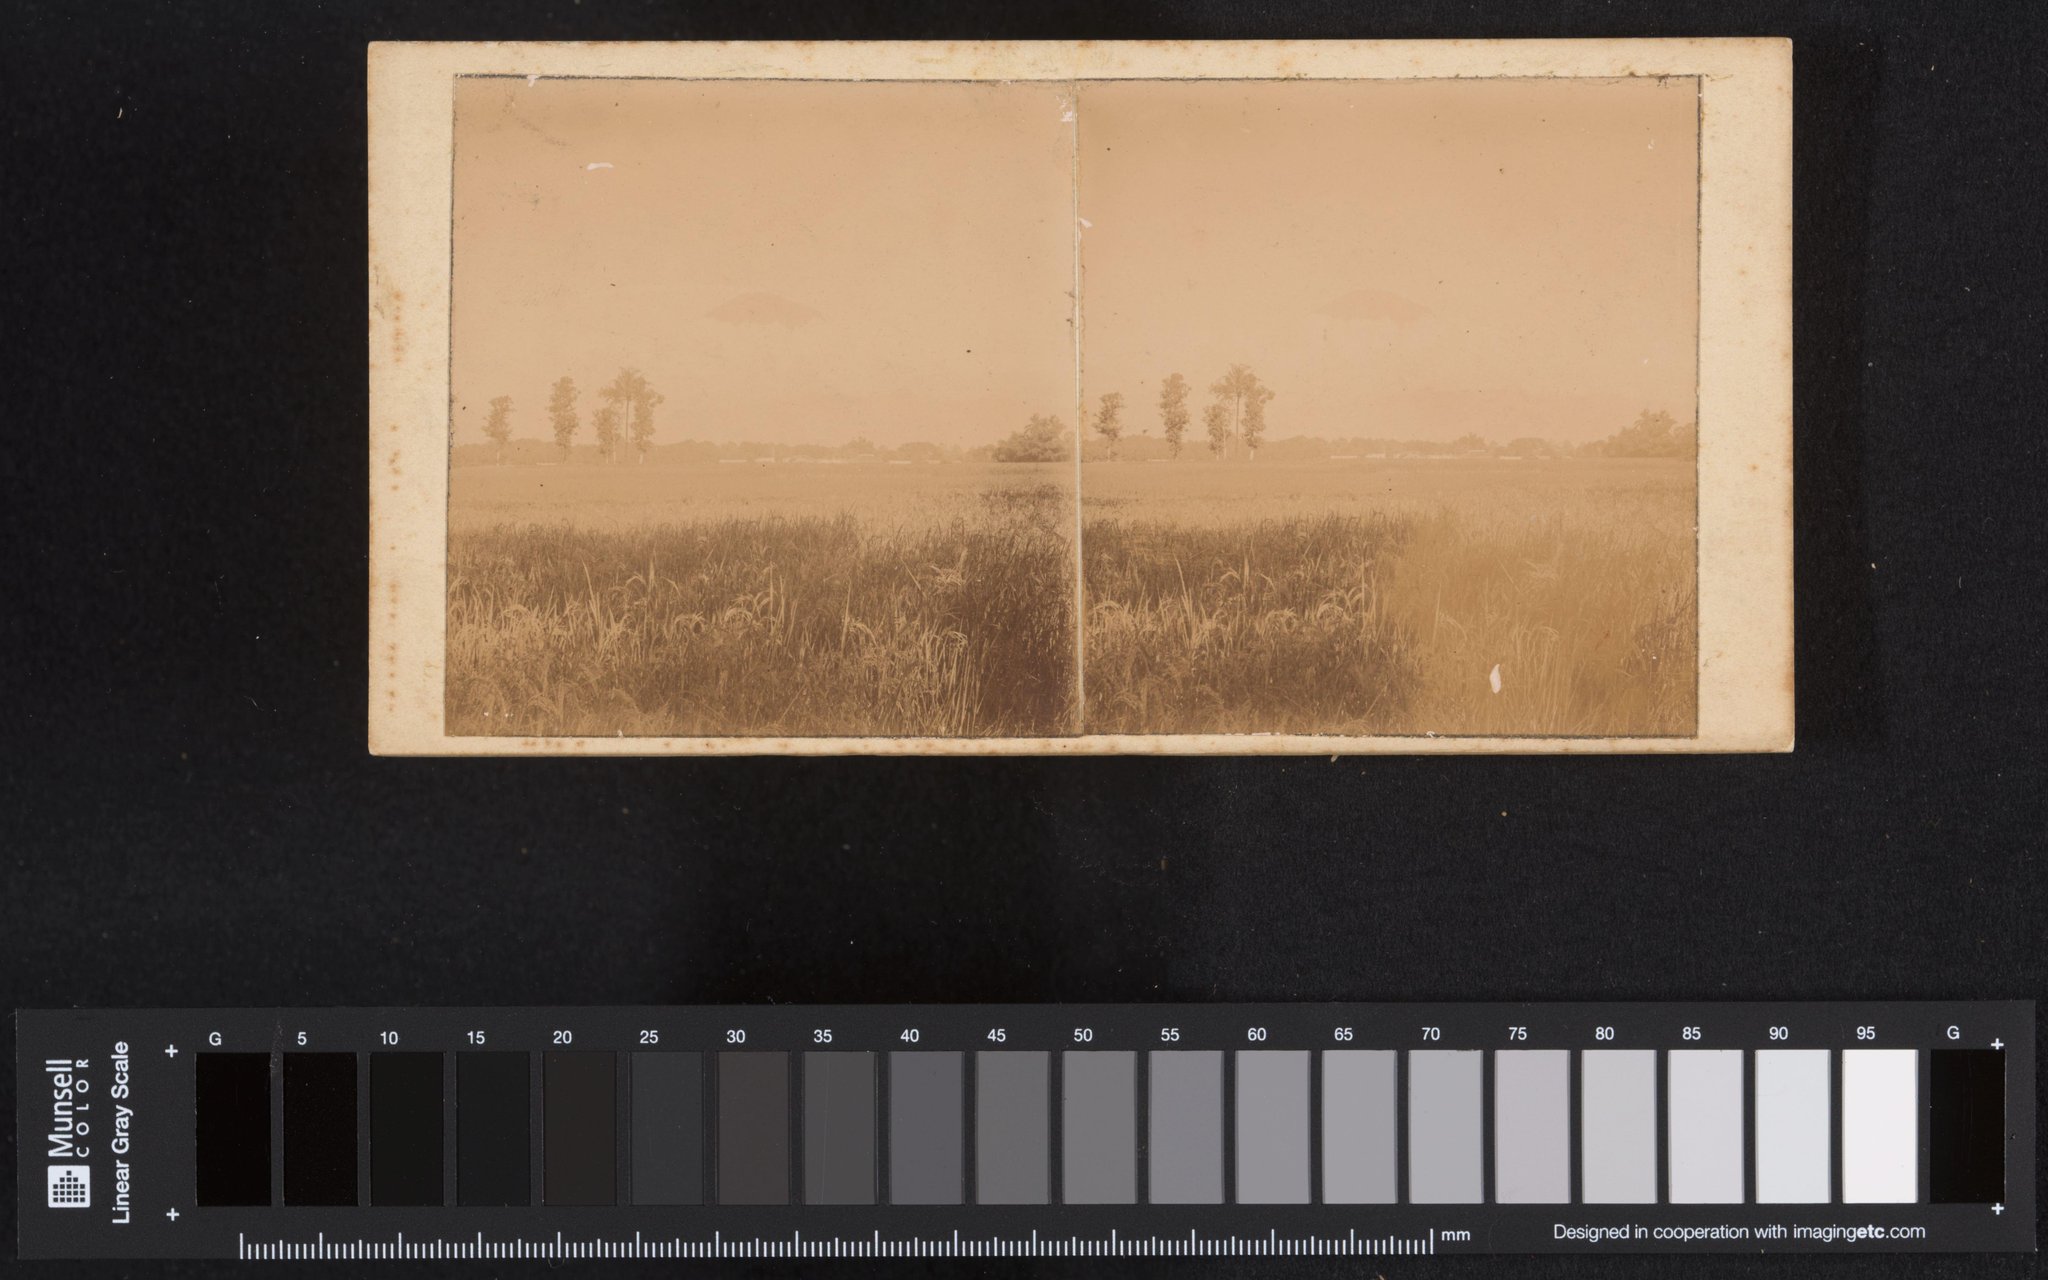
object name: stereograph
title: Rijstvelden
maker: robert julius boers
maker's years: 1867-1932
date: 1900-1922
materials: cardboard, photographic support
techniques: gelatin silver print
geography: bangka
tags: robert julius boers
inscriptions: inscription: ‘Paddivelden buiten Majelang met gezicht op de Meibaboe’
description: Landschap met rijstvelden op Banka. Onderdeel van een groep stereofoto's van Robert Julius Boers, chef van het staatsbedrijf de Banka-tinwinning op Banka, uit de periode ca. 1900-1922.